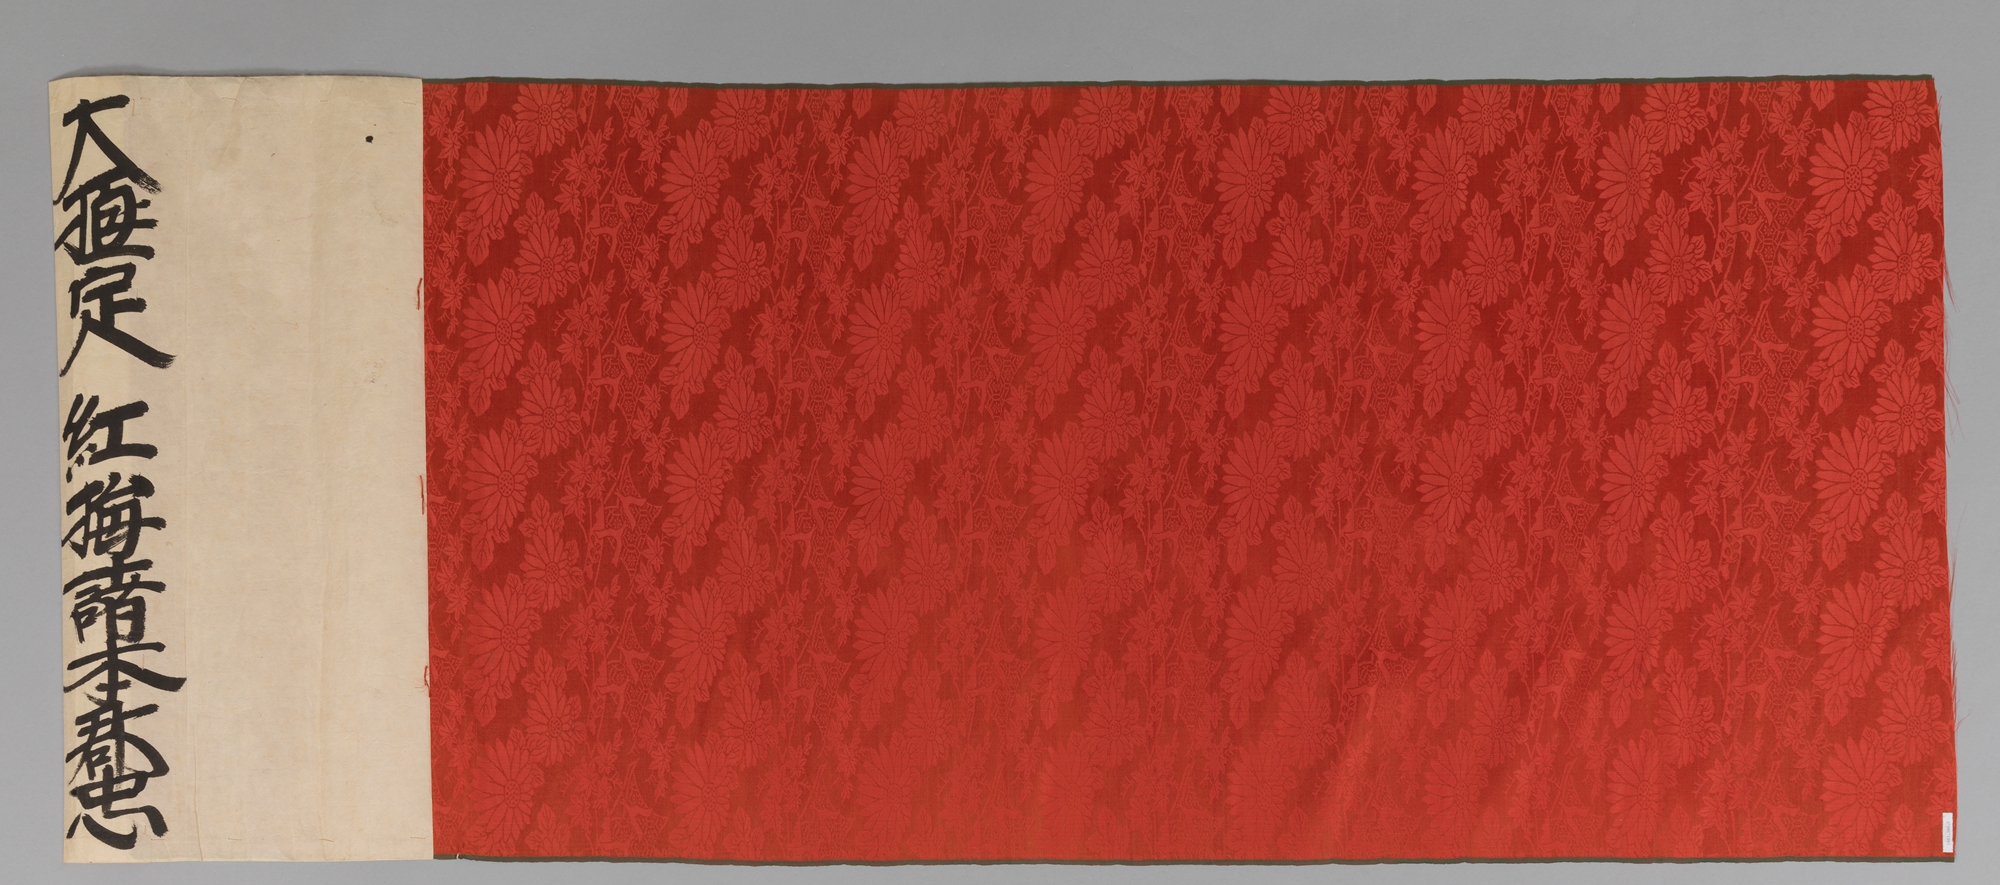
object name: panel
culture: japanese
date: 1801-1900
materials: silk